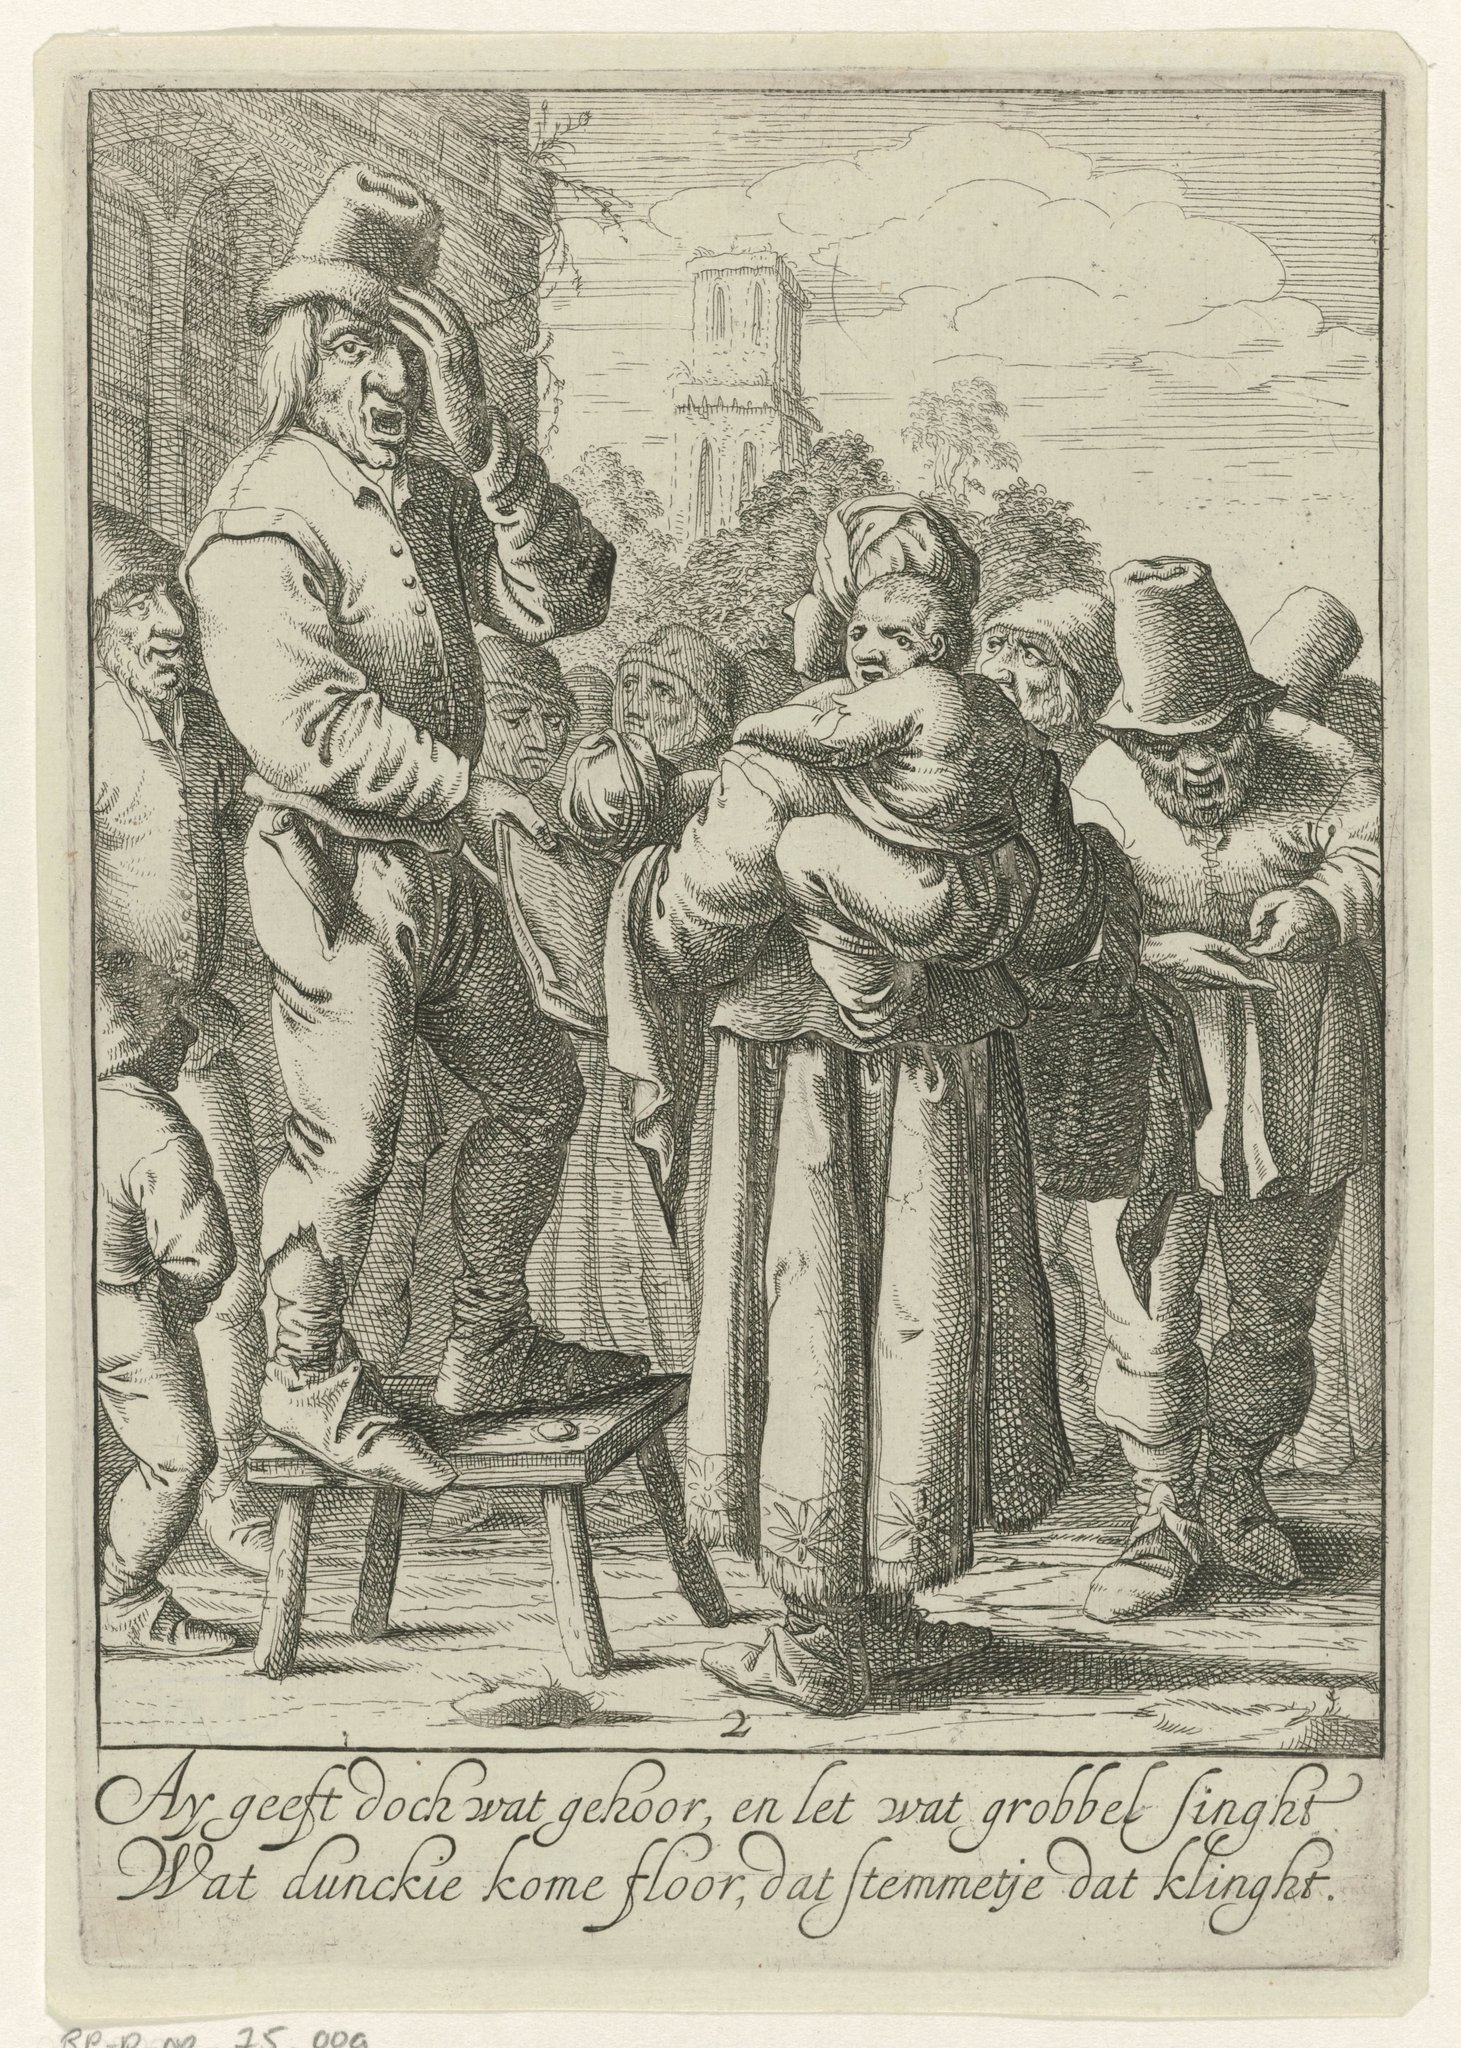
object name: print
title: De vijf zintuigen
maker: clement de jonghe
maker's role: print maker, publisher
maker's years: 1624-1677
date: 1640-1670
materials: paper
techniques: etching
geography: amsterdam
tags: hearing, listening (one of the five senses), vocal music, singing - cc - out of doors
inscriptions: number: ‘2’, caption: ‘Ay geeft doch wat gehoor, en let wat grobbe singht / Wat dunckie kome floor, dat stemmetje dat klinght’, collector's mark: Lugt 2228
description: Een man staat op een kruk te zingen. Rondom hem staan toeschouwers. Onder de voorstelling een tweeregelig vers in het Nederlands. De prent maakt deel uit van een serie van vijf prenten met de vijf zintuigen.